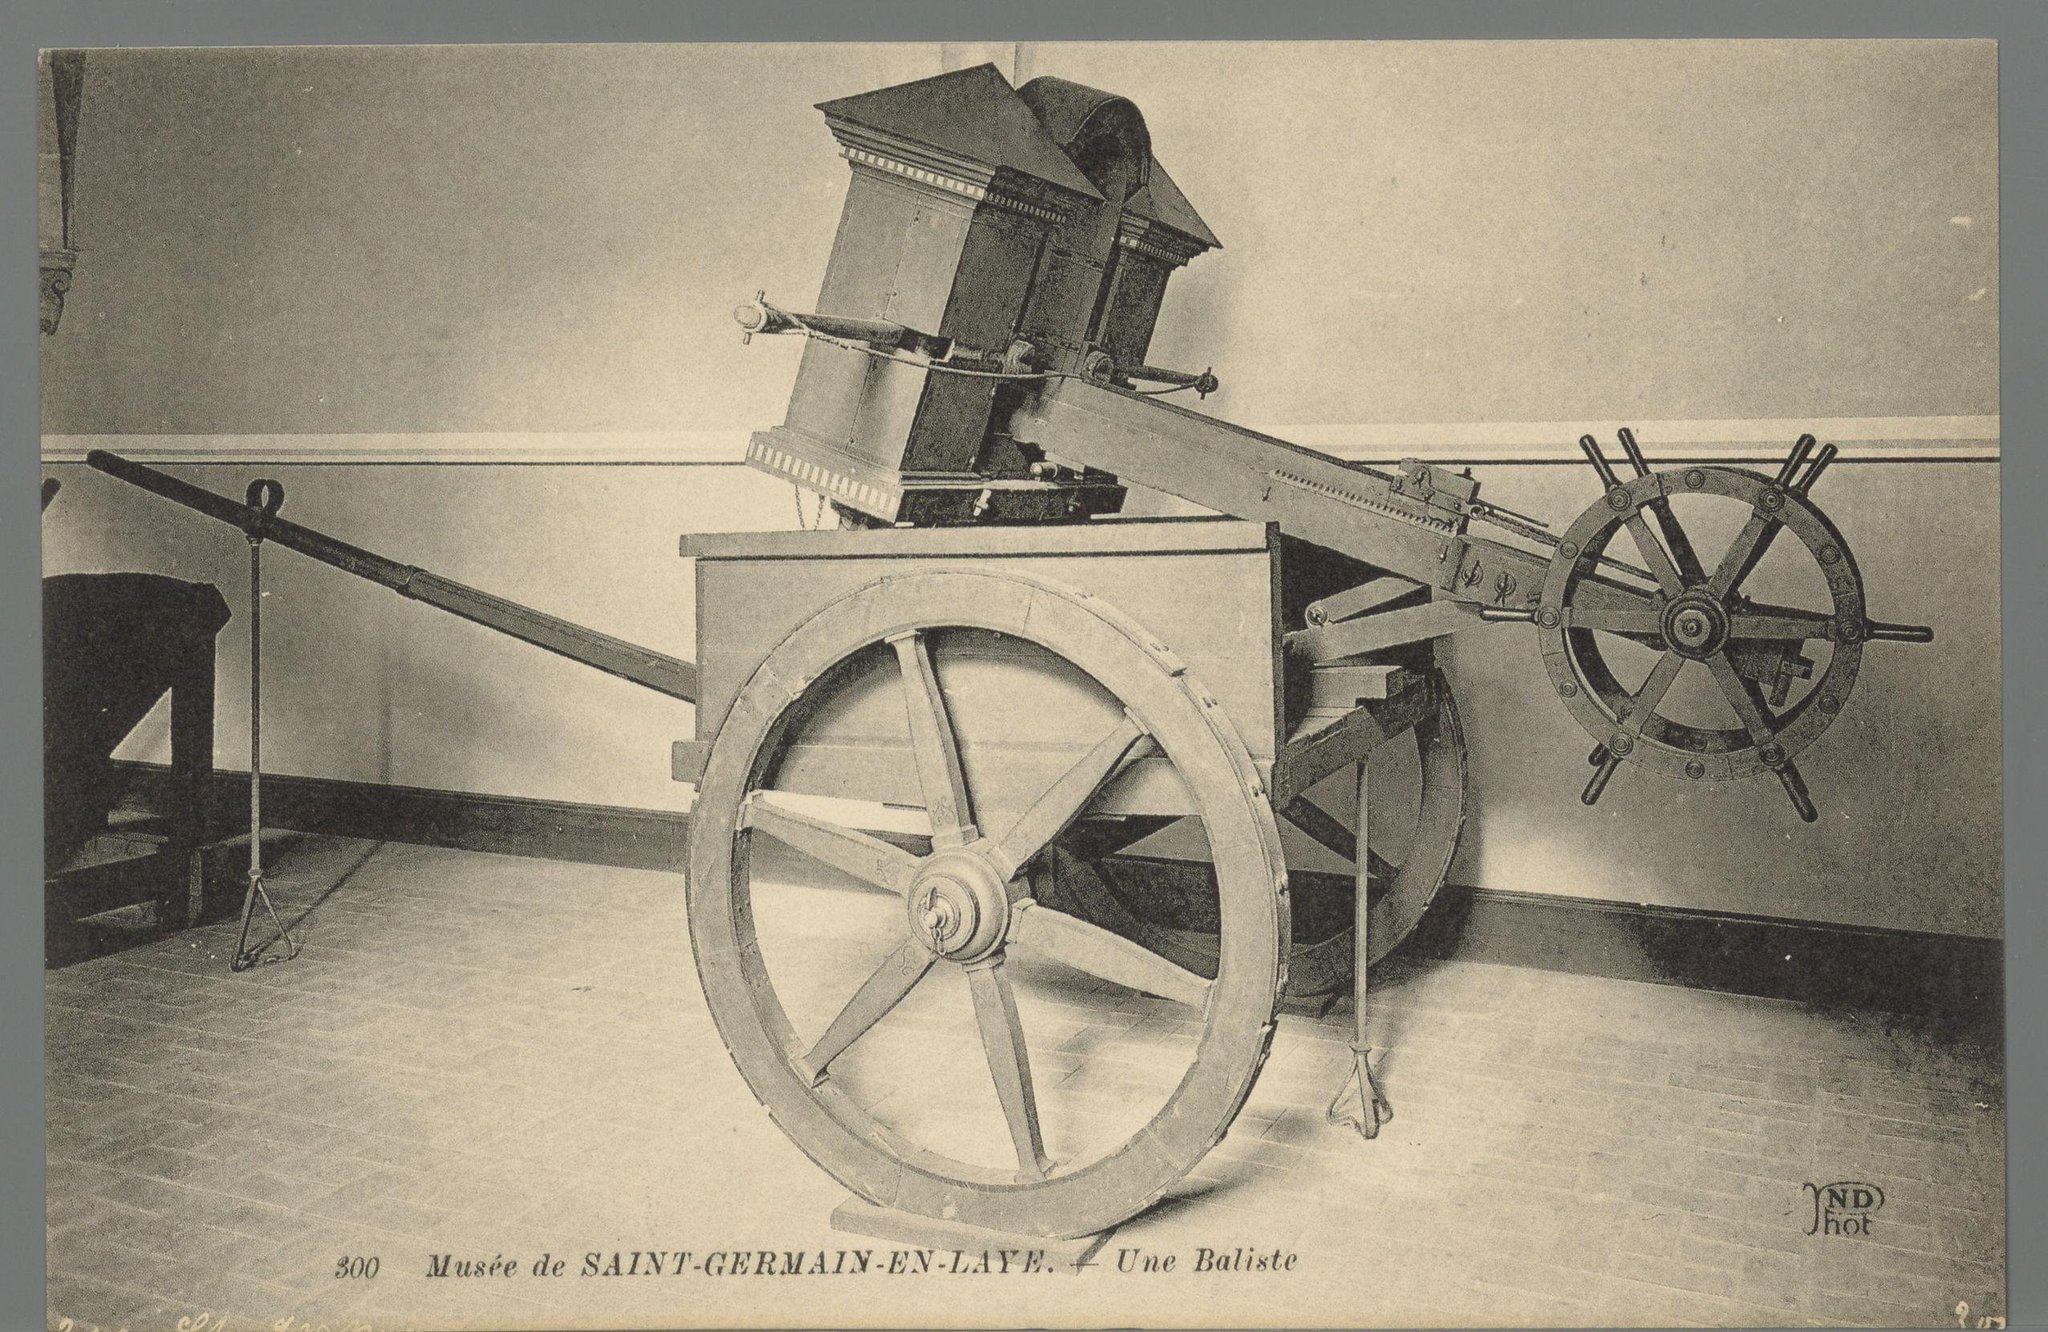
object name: ansichtkaart, prentbriefkaart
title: Une Baliste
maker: Anonymous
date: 1903-1918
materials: cardboard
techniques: photograph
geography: saint-germain-en-laye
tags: weapons for striking a blow, permanent exhibition, museum